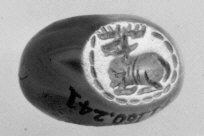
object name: stamp seal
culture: sasanian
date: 201-700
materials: stone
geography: iran or mesopotamia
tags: deer